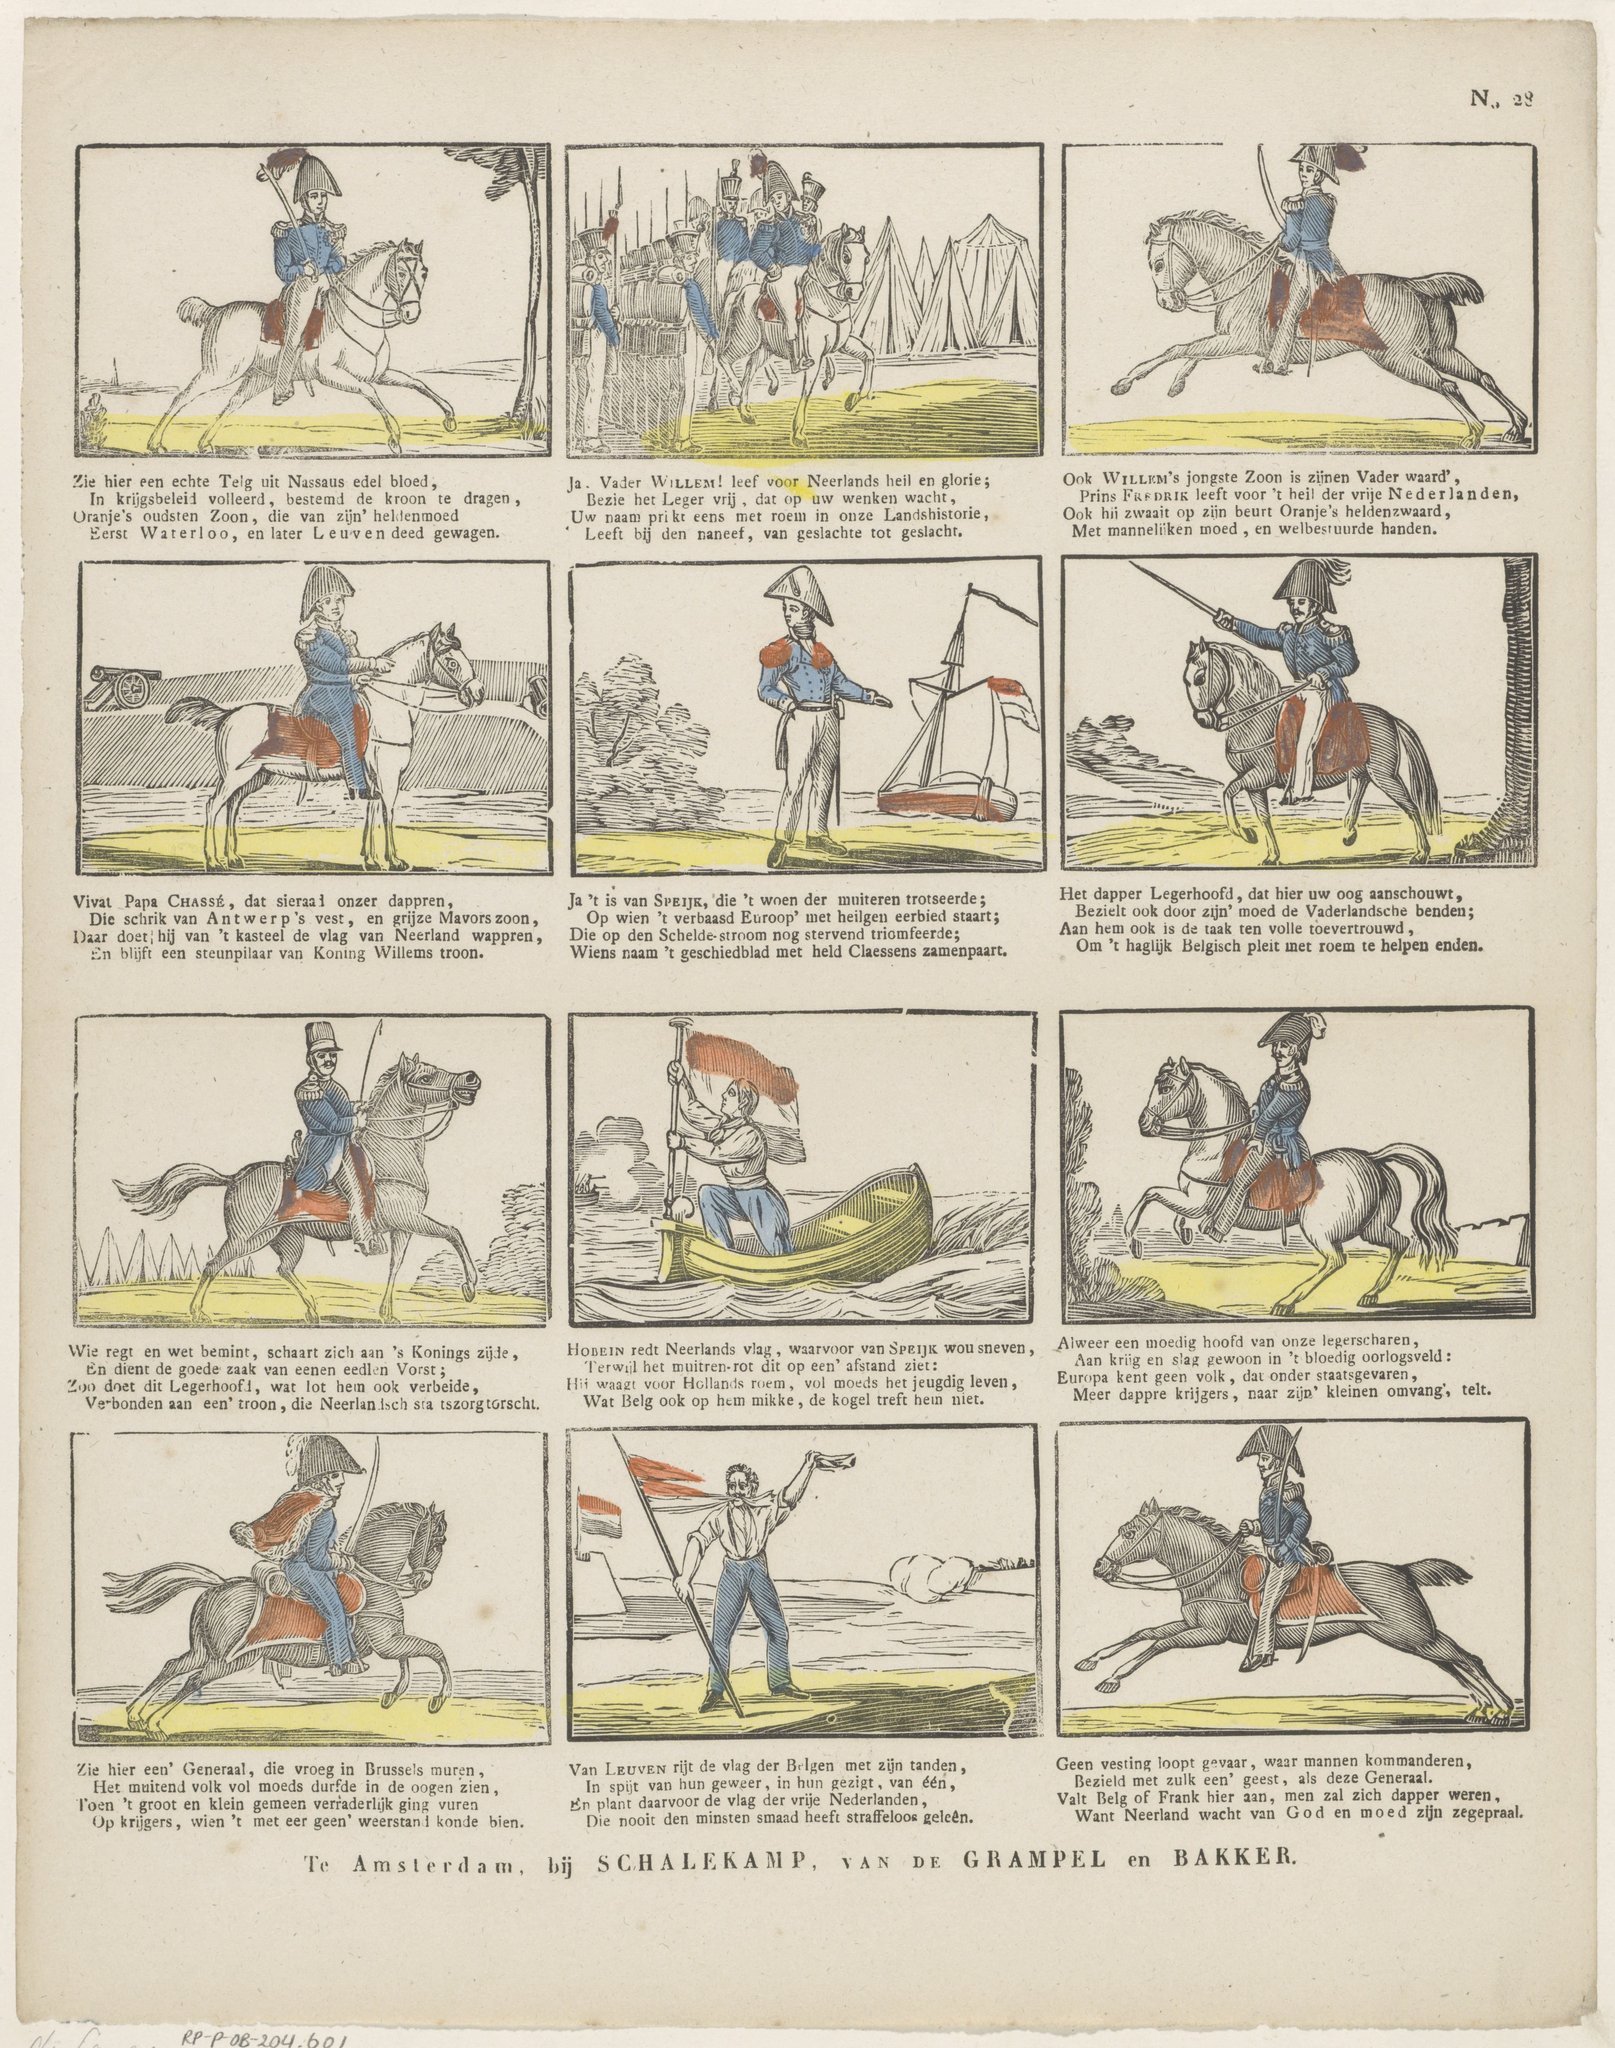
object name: print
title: Belgische Revolutie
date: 1822-1849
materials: paper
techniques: colour, letterpress printing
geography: netherlands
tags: antwerp, jan van speyk, the hague, berlin, william i of the netherlands, frederik (prins der nederlanden), battle, warfare; military affairs (+ cavalry, horsemen), the soldier; the soldier's life, netherlands, belgium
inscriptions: collector's mark: Lugt 2760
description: Uitgave van nr. 28 uit de fondslijst van Jan de Lange (II) met het adres van de wederverkoper Schalekamp, Van de Grampel & Bakker.